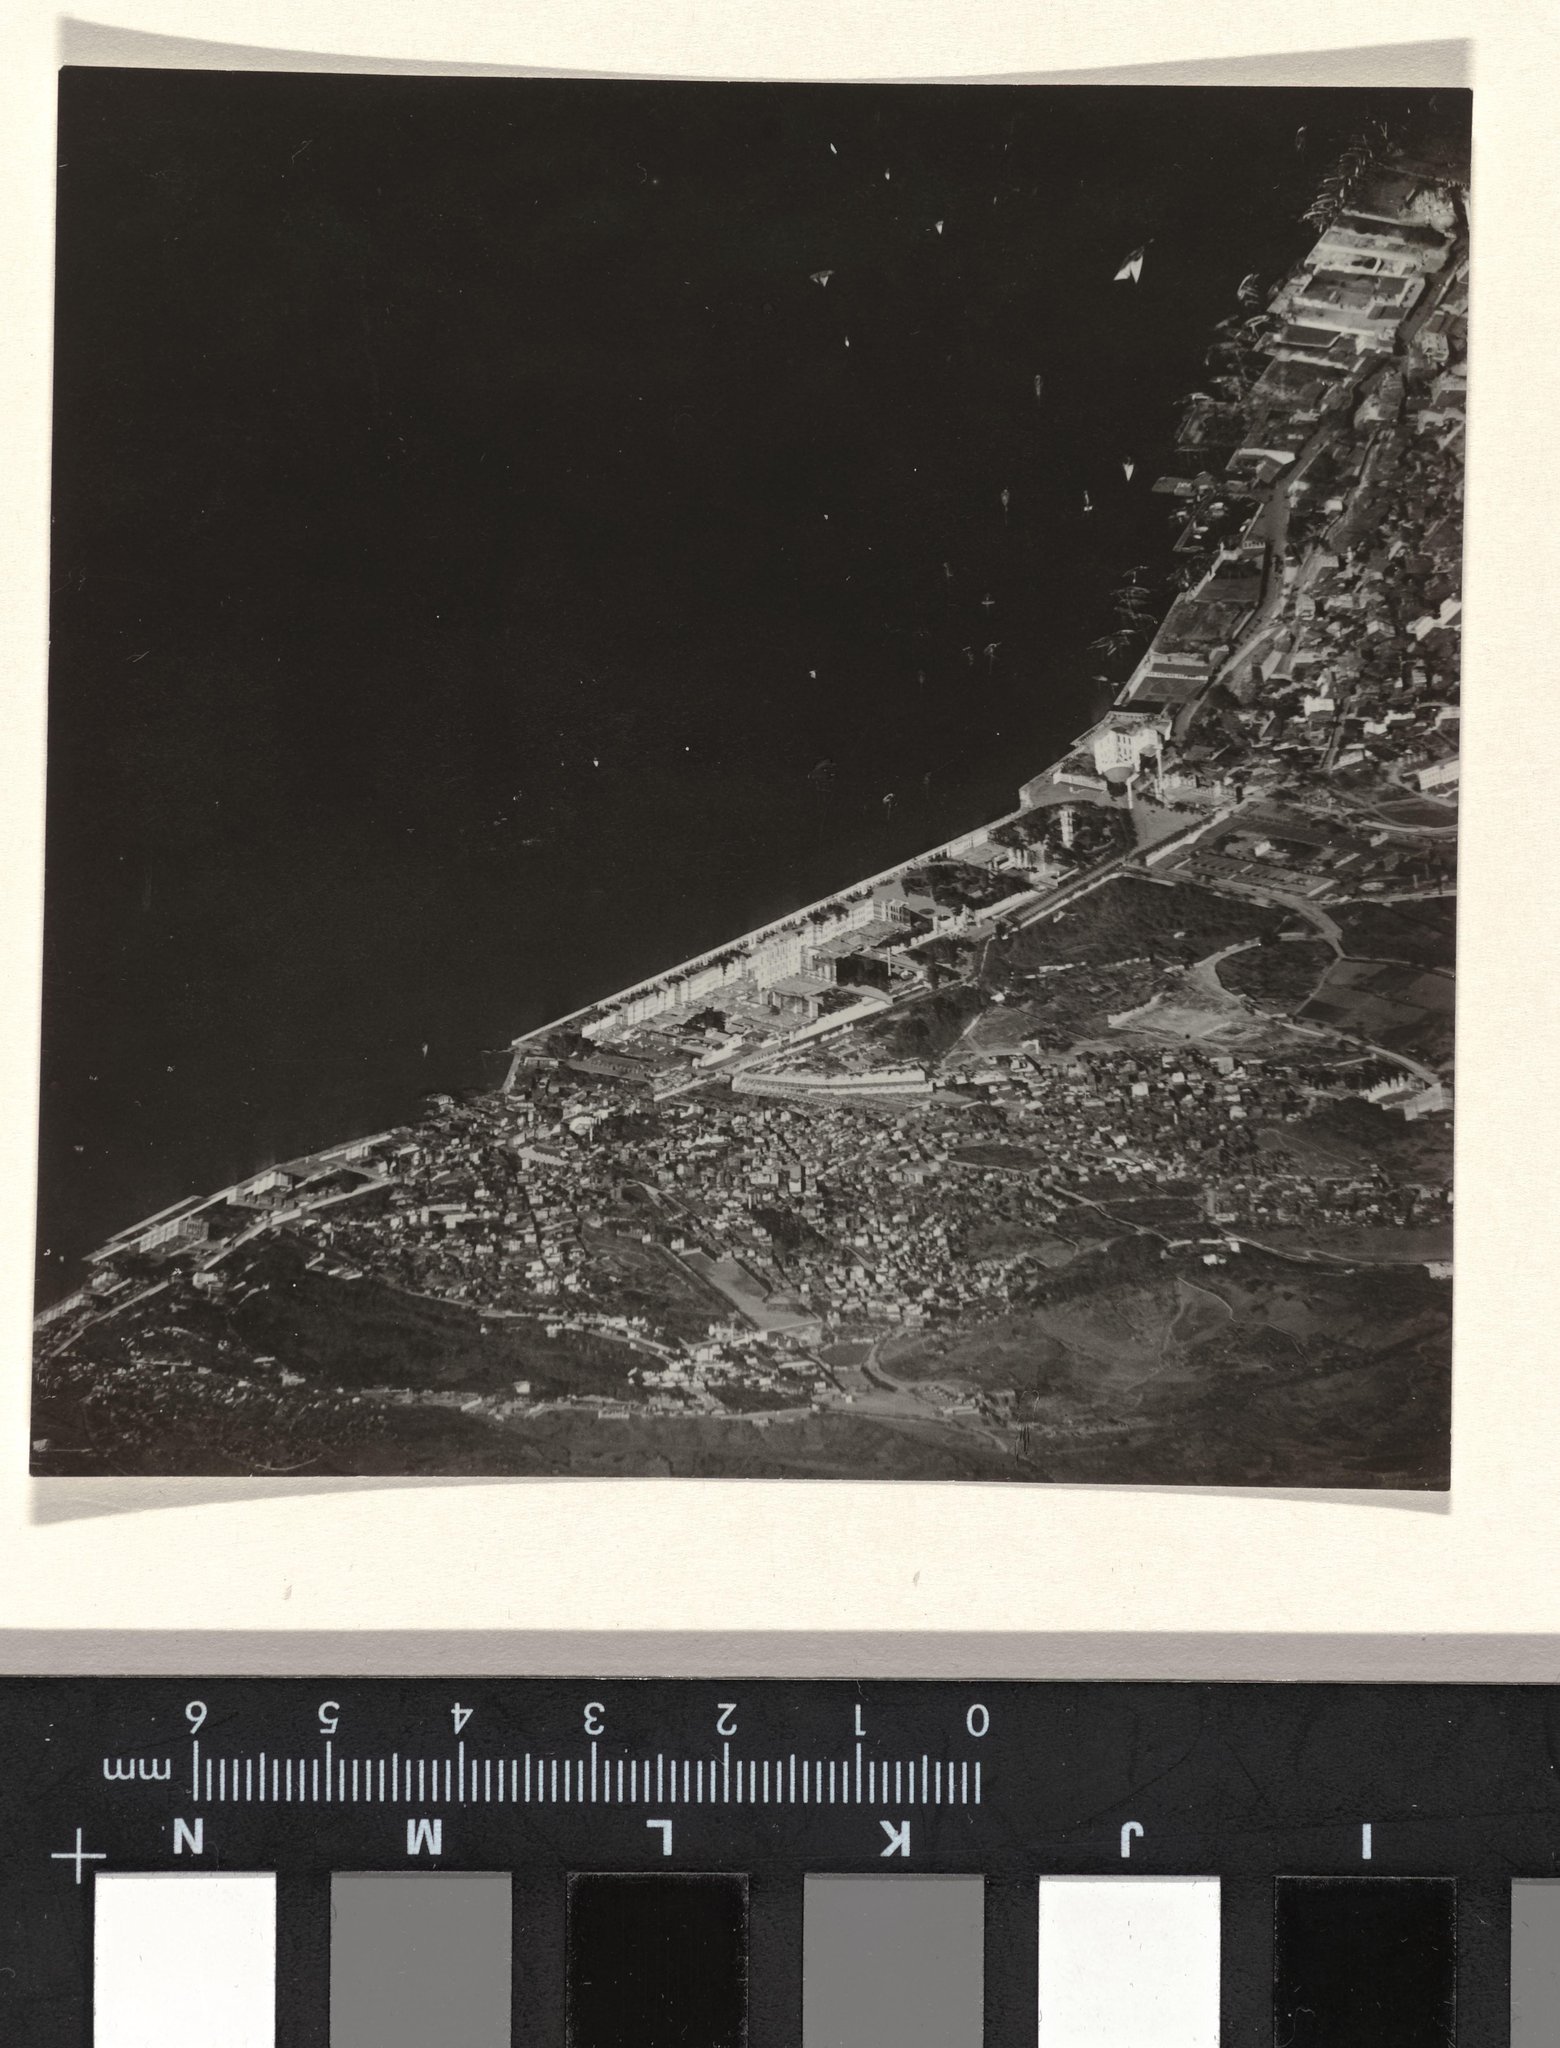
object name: photograph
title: Luchtfoto van Istanbul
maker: Anonymous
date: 1930-1975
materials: photographic support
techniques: gelatin silver print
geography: istanbul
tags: istanboel